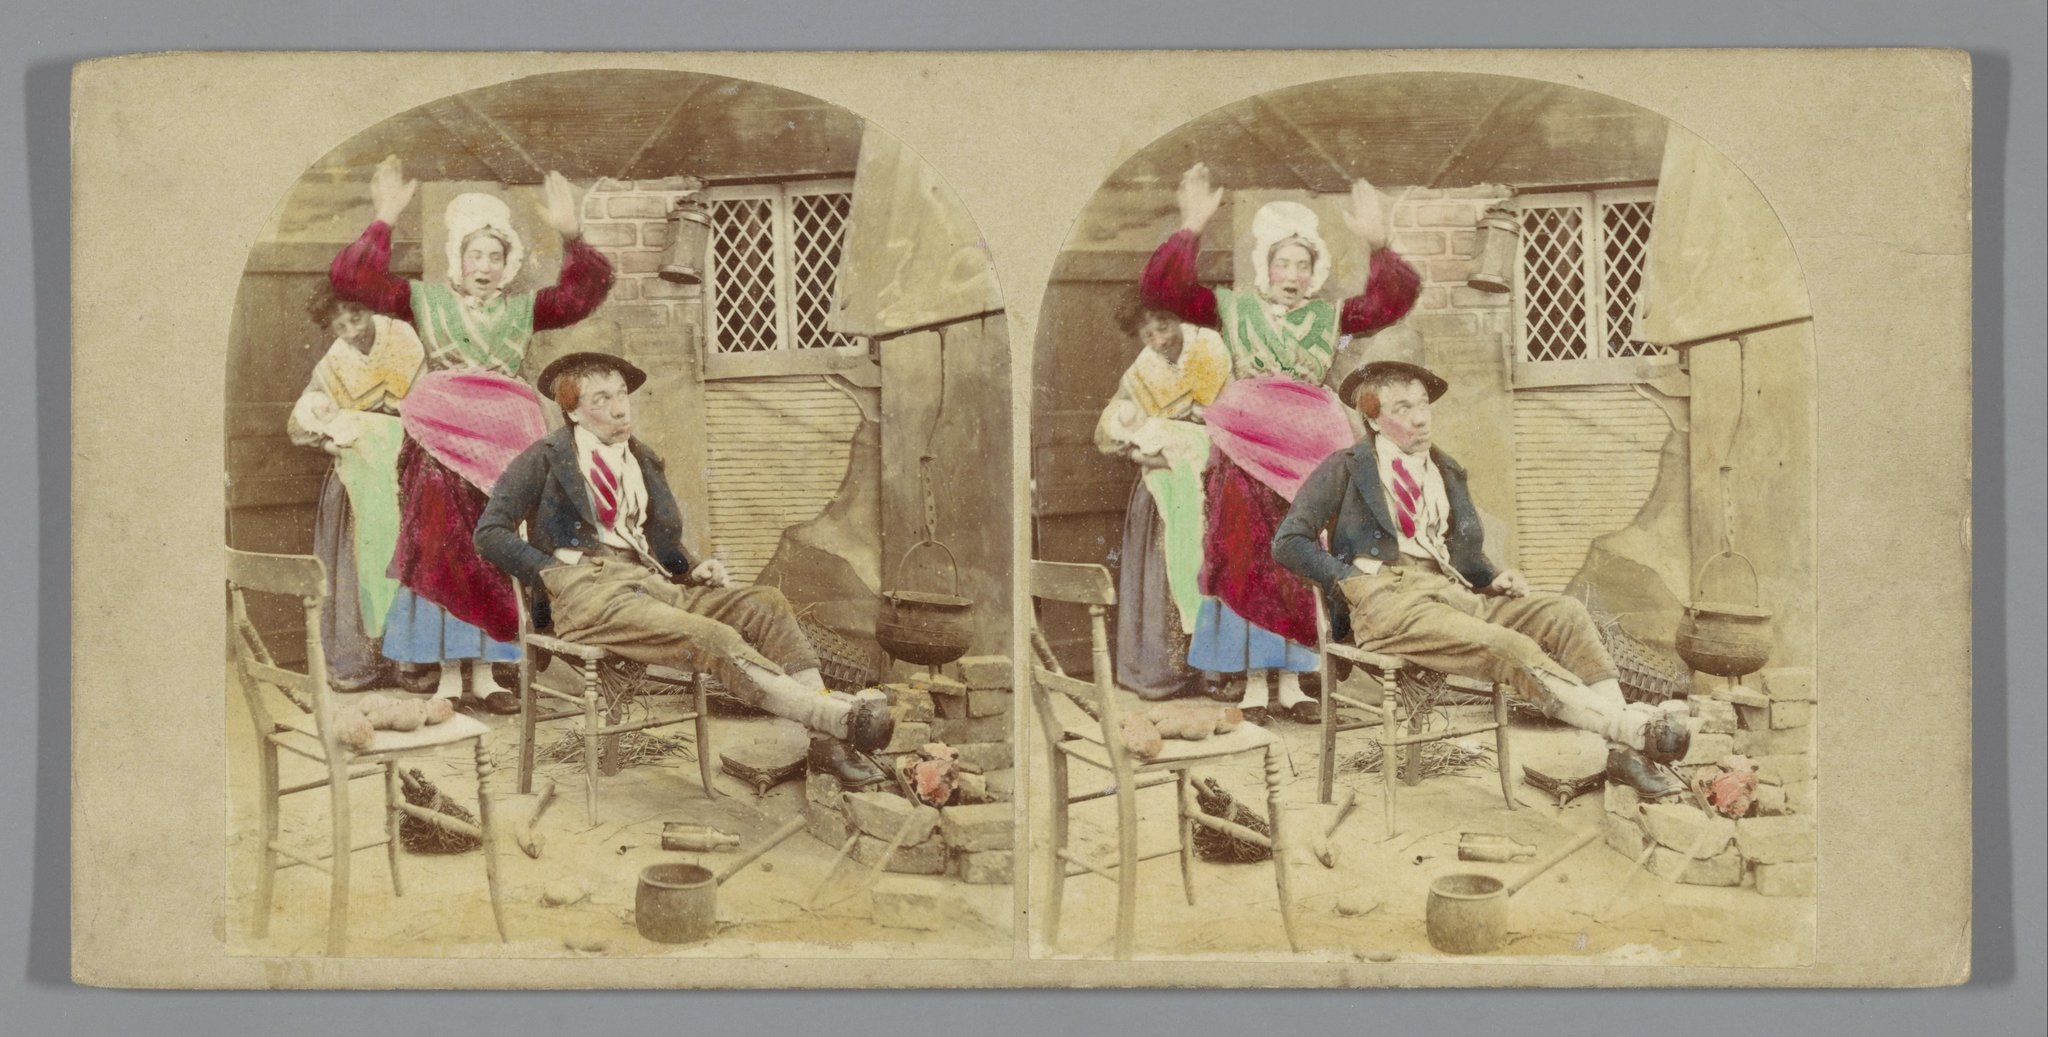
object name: stereograph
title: Man zittend naast een vuur in een keuken met daarachter twee mensen en een baby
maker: Anonymous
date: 1852-1863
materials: cardboard, paper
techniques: albumen print, hand coloring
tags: first care of new-born baby, family life at home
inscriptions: copyright notice: ‘Copyright.’